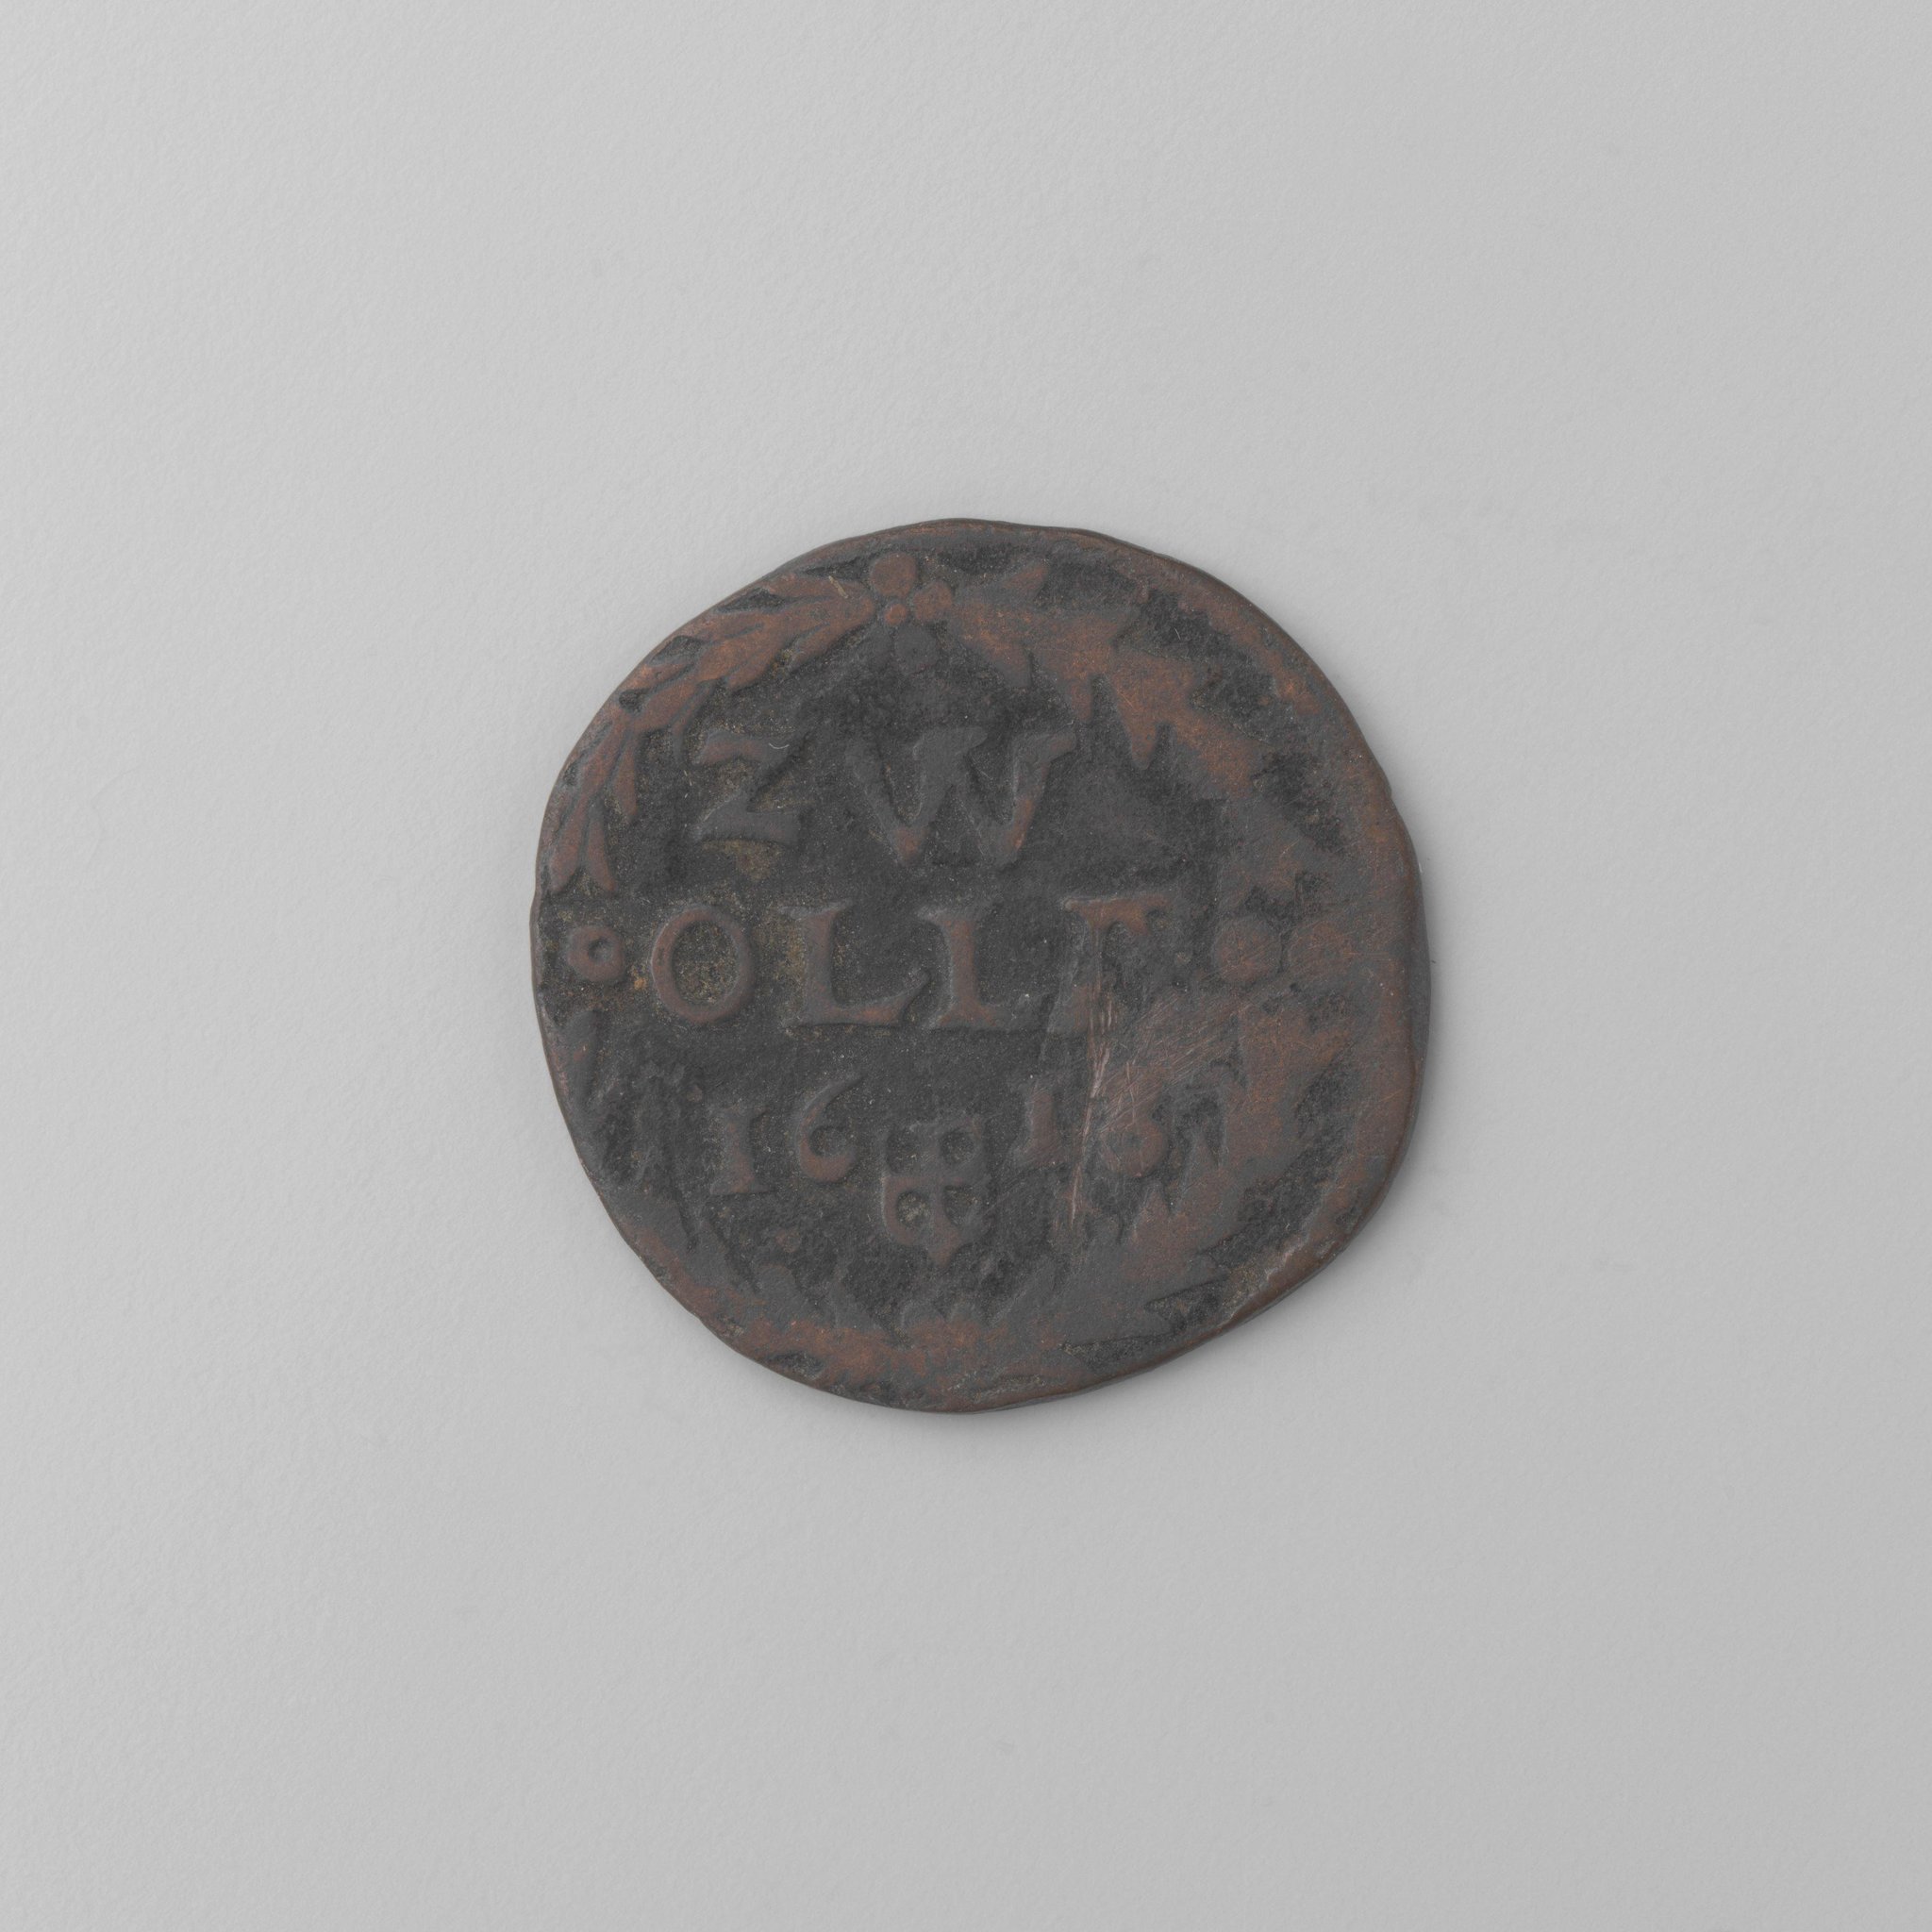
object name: coin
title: Zwolse duit, 1618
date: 1618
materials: copper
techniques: striking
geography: zwolle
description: Koperen munt. Voorzijde: versierd wapenschild van Zwolle. Keerzijde: binnen krans tweeregelig opschrift, waaronder jaartal tussen wapenschildje.